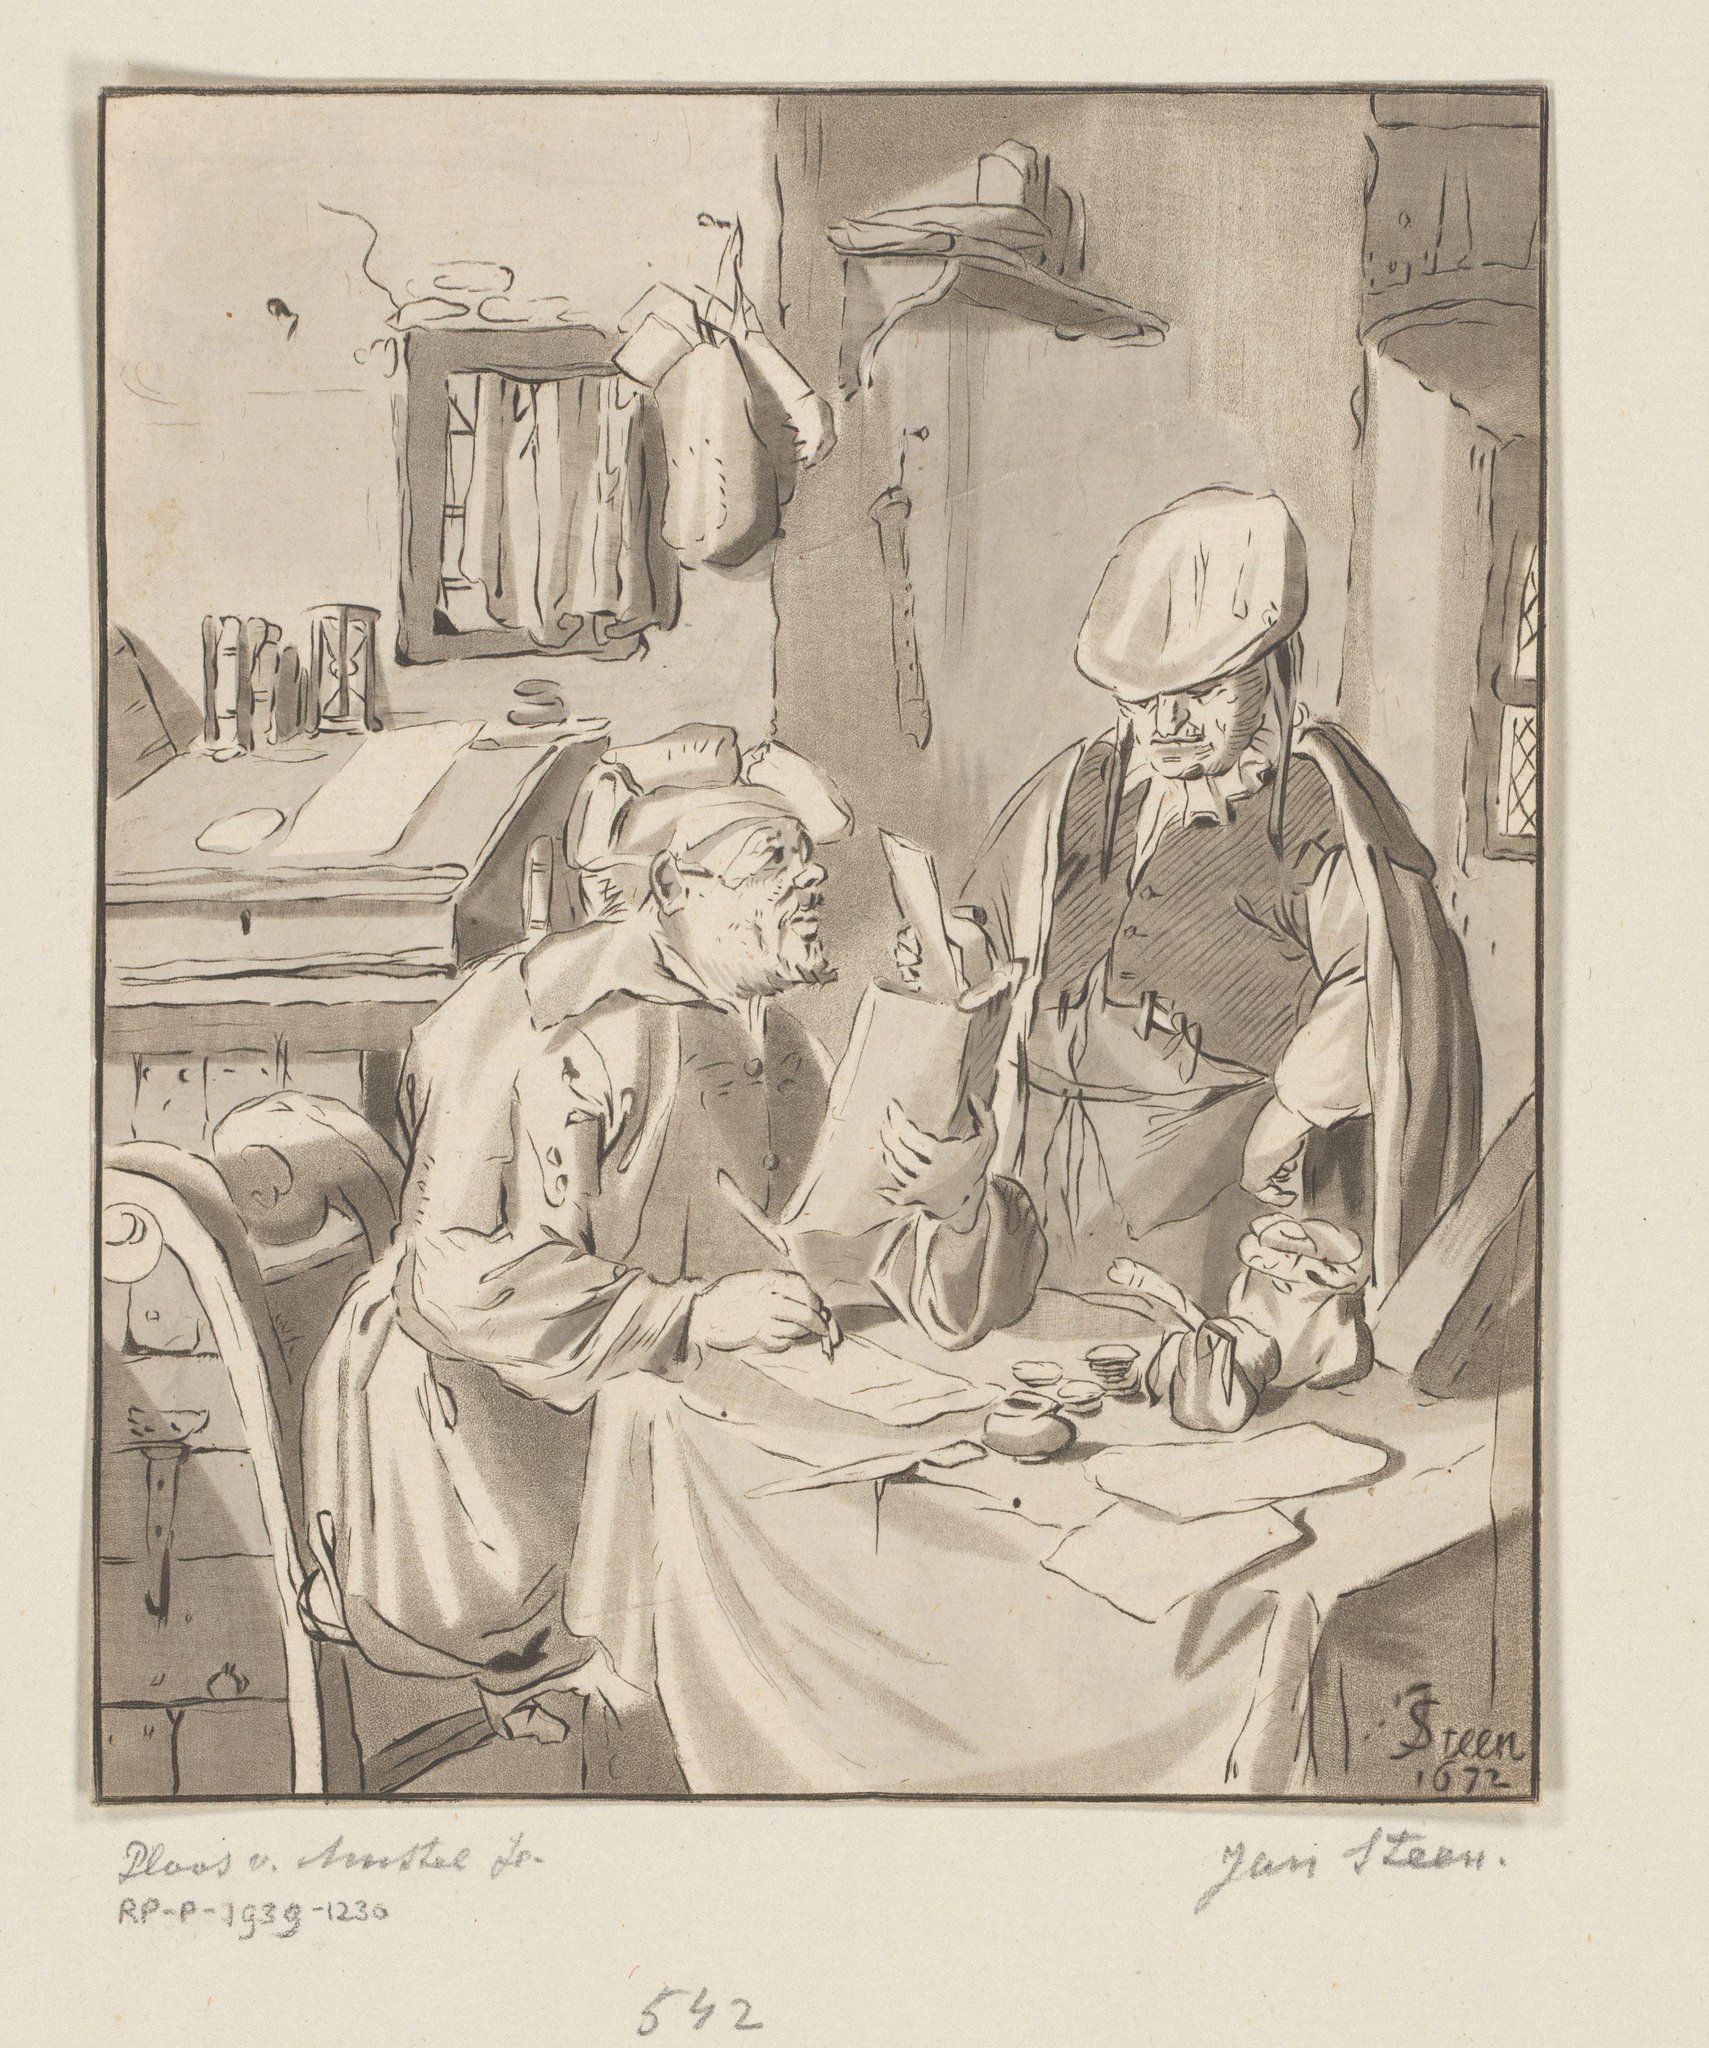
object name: print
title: Schrijver van een brief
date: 1777-1786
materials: paper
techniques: etching, hand coloring, roulette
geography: amsterdam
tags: sitting figure, writing tools, letter, envelope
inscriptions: collector's mark: ‘RIJKS / MUSM’, collector's mark: Lugt 2725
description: Een man, zittend aan een tafel, schrijft een brief. Naast hem staat een man met een brief in de hand. De prent ligt los in een album, zie blad 38.